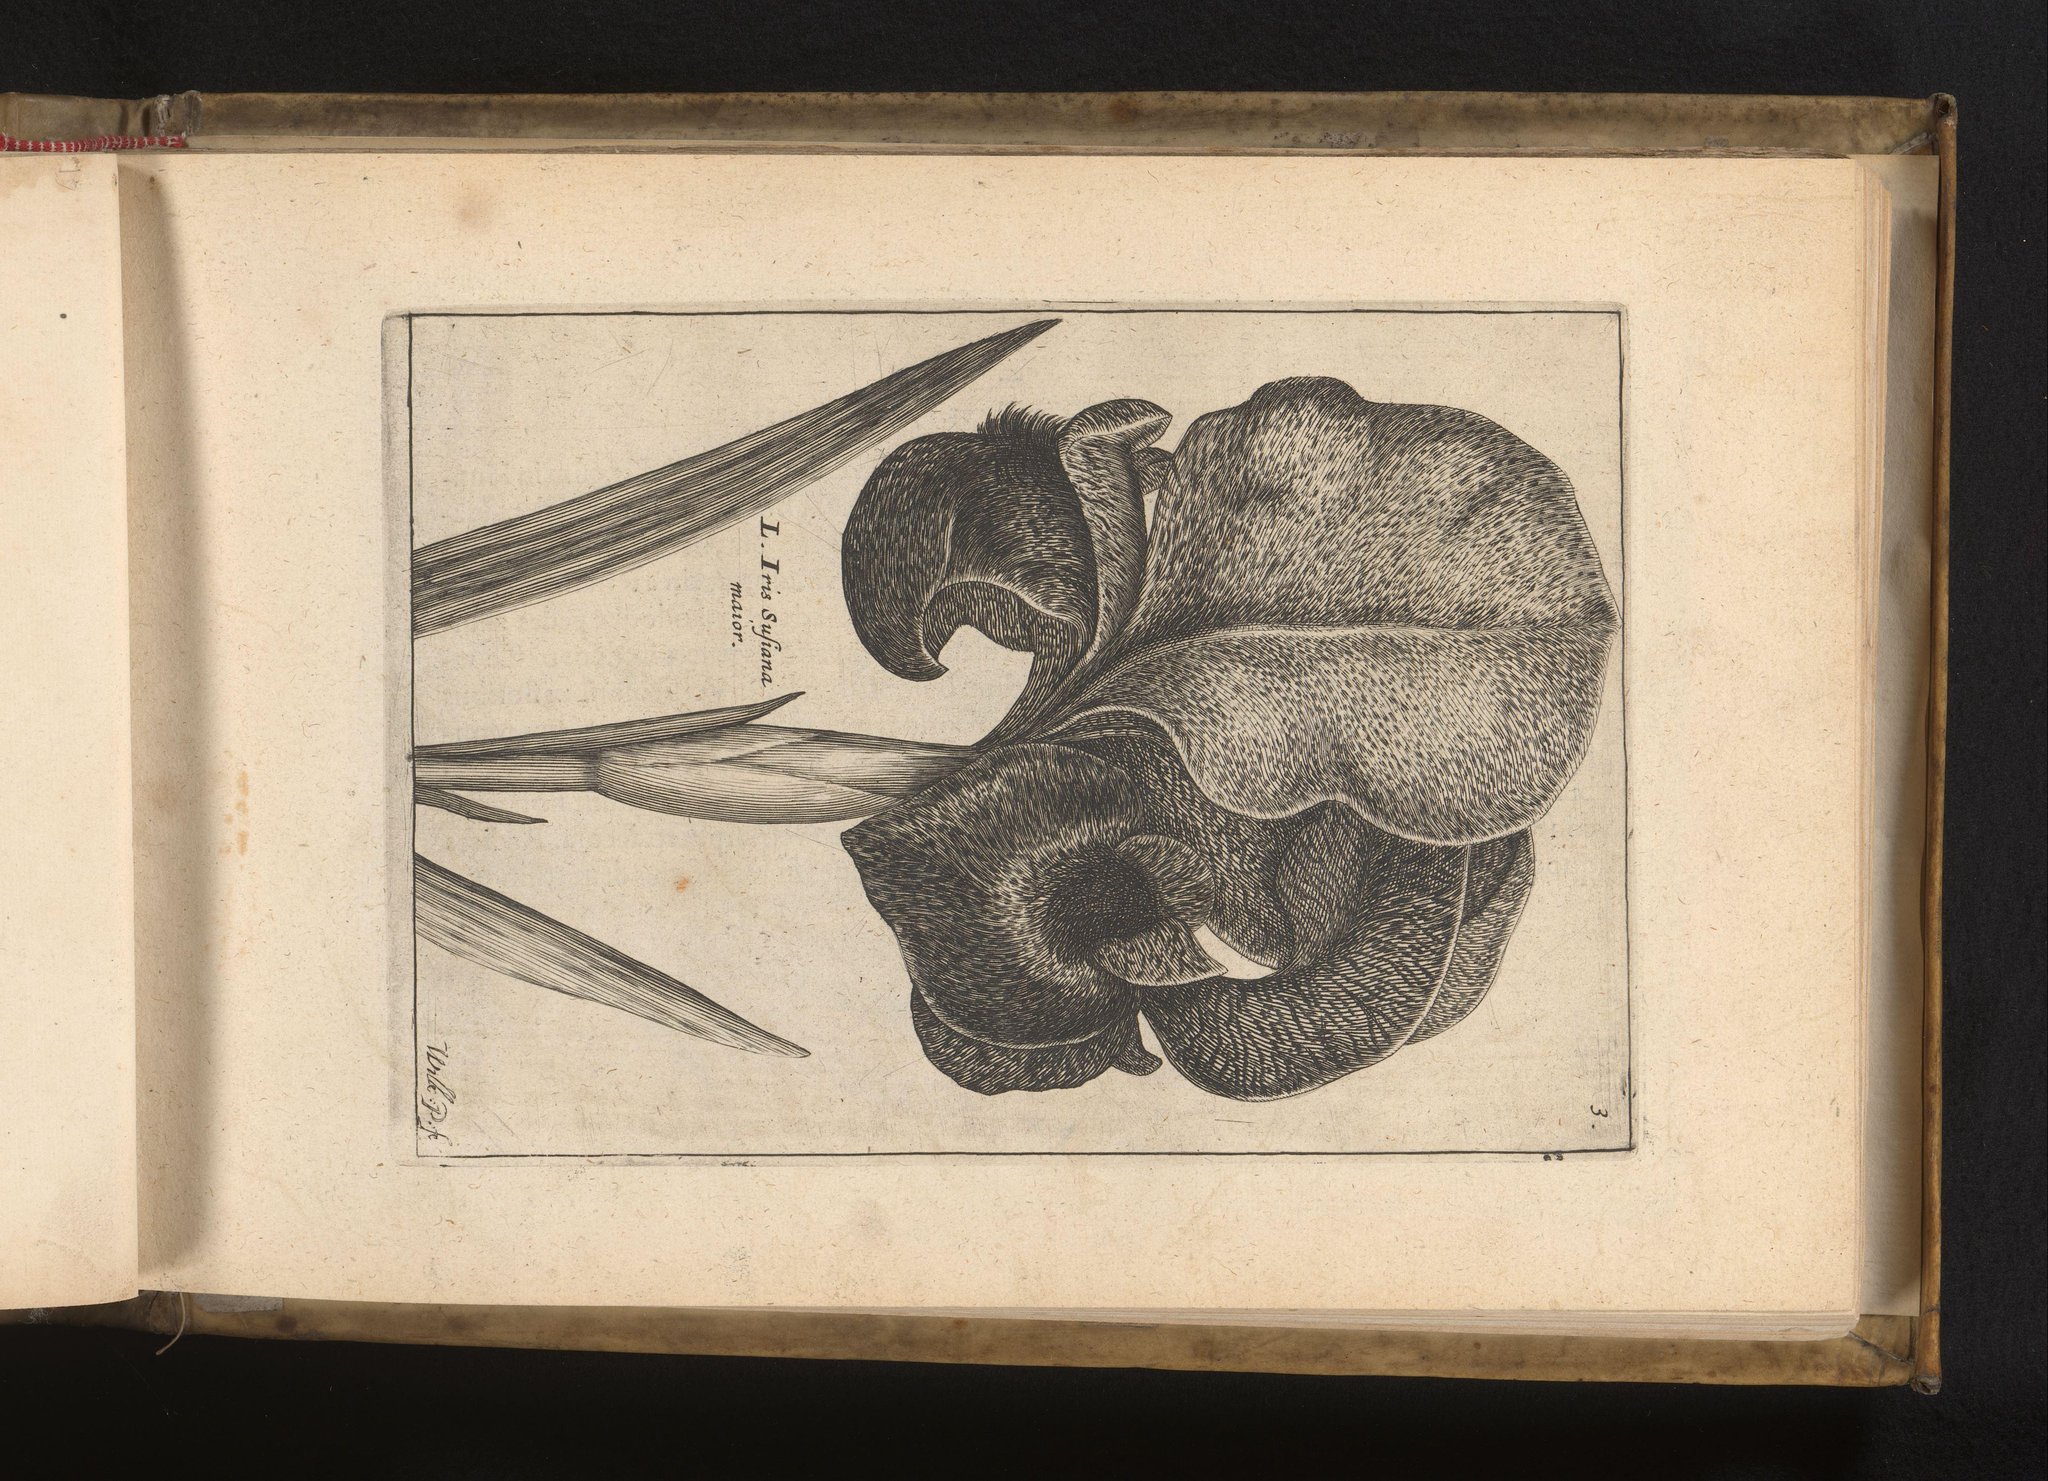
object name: print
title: Rouwiris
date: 1617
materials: paper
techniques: engraving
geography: arnhem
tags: flowers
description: Prent uit: Passe, Crispijn van de (II). Hortus floridus in quo rariorum & minus vulgarium florum icones ad vivam veramque formam. Arnhem: Johannes Janssonius, 1617.